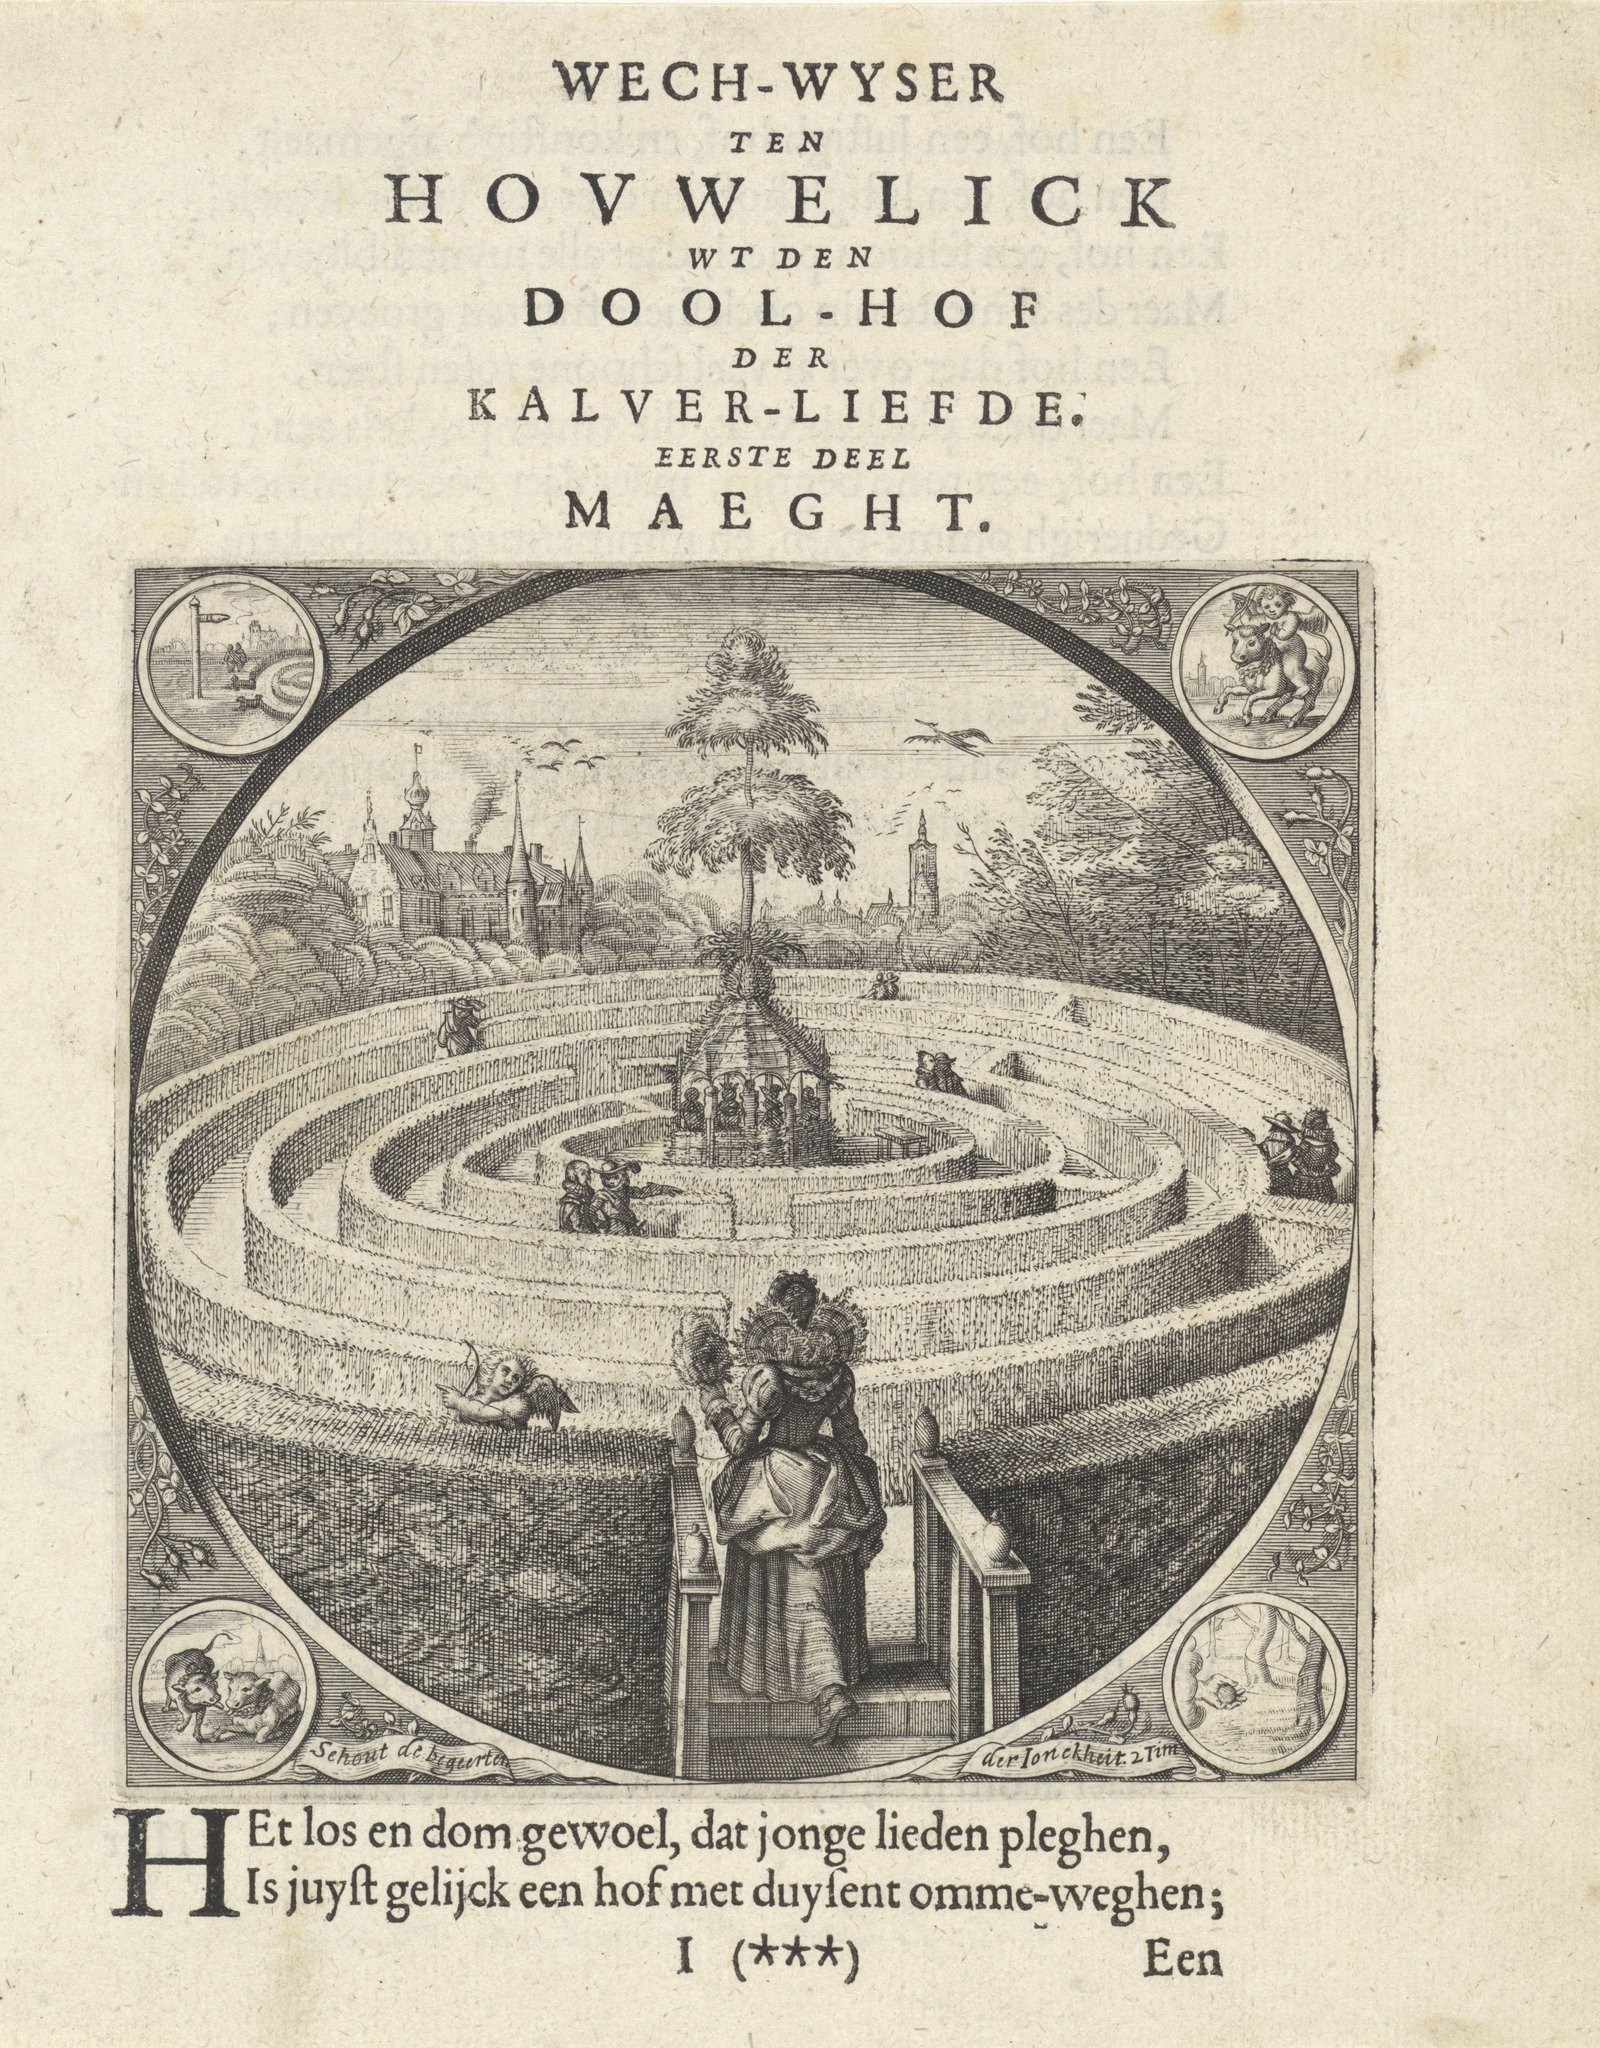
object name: print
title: Vrouw treedt een doolhof binnen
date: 1625-1635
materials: paper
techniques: engraving, letterpress printing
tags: labyrinth, maze ~ garden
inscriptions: collector's mark: Lugt 2228, collector's mark: Lugt 2760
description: Boekillustratie in: Cats, Jacob. Hovwelyck. Dat is De gansche gelegentheyt des echten staets. Middelburg: Jan Pietersz van de Venne (wed.),1625-1626 en 's-Gravenhage: Adriaen van de Venne, 1625-1635.